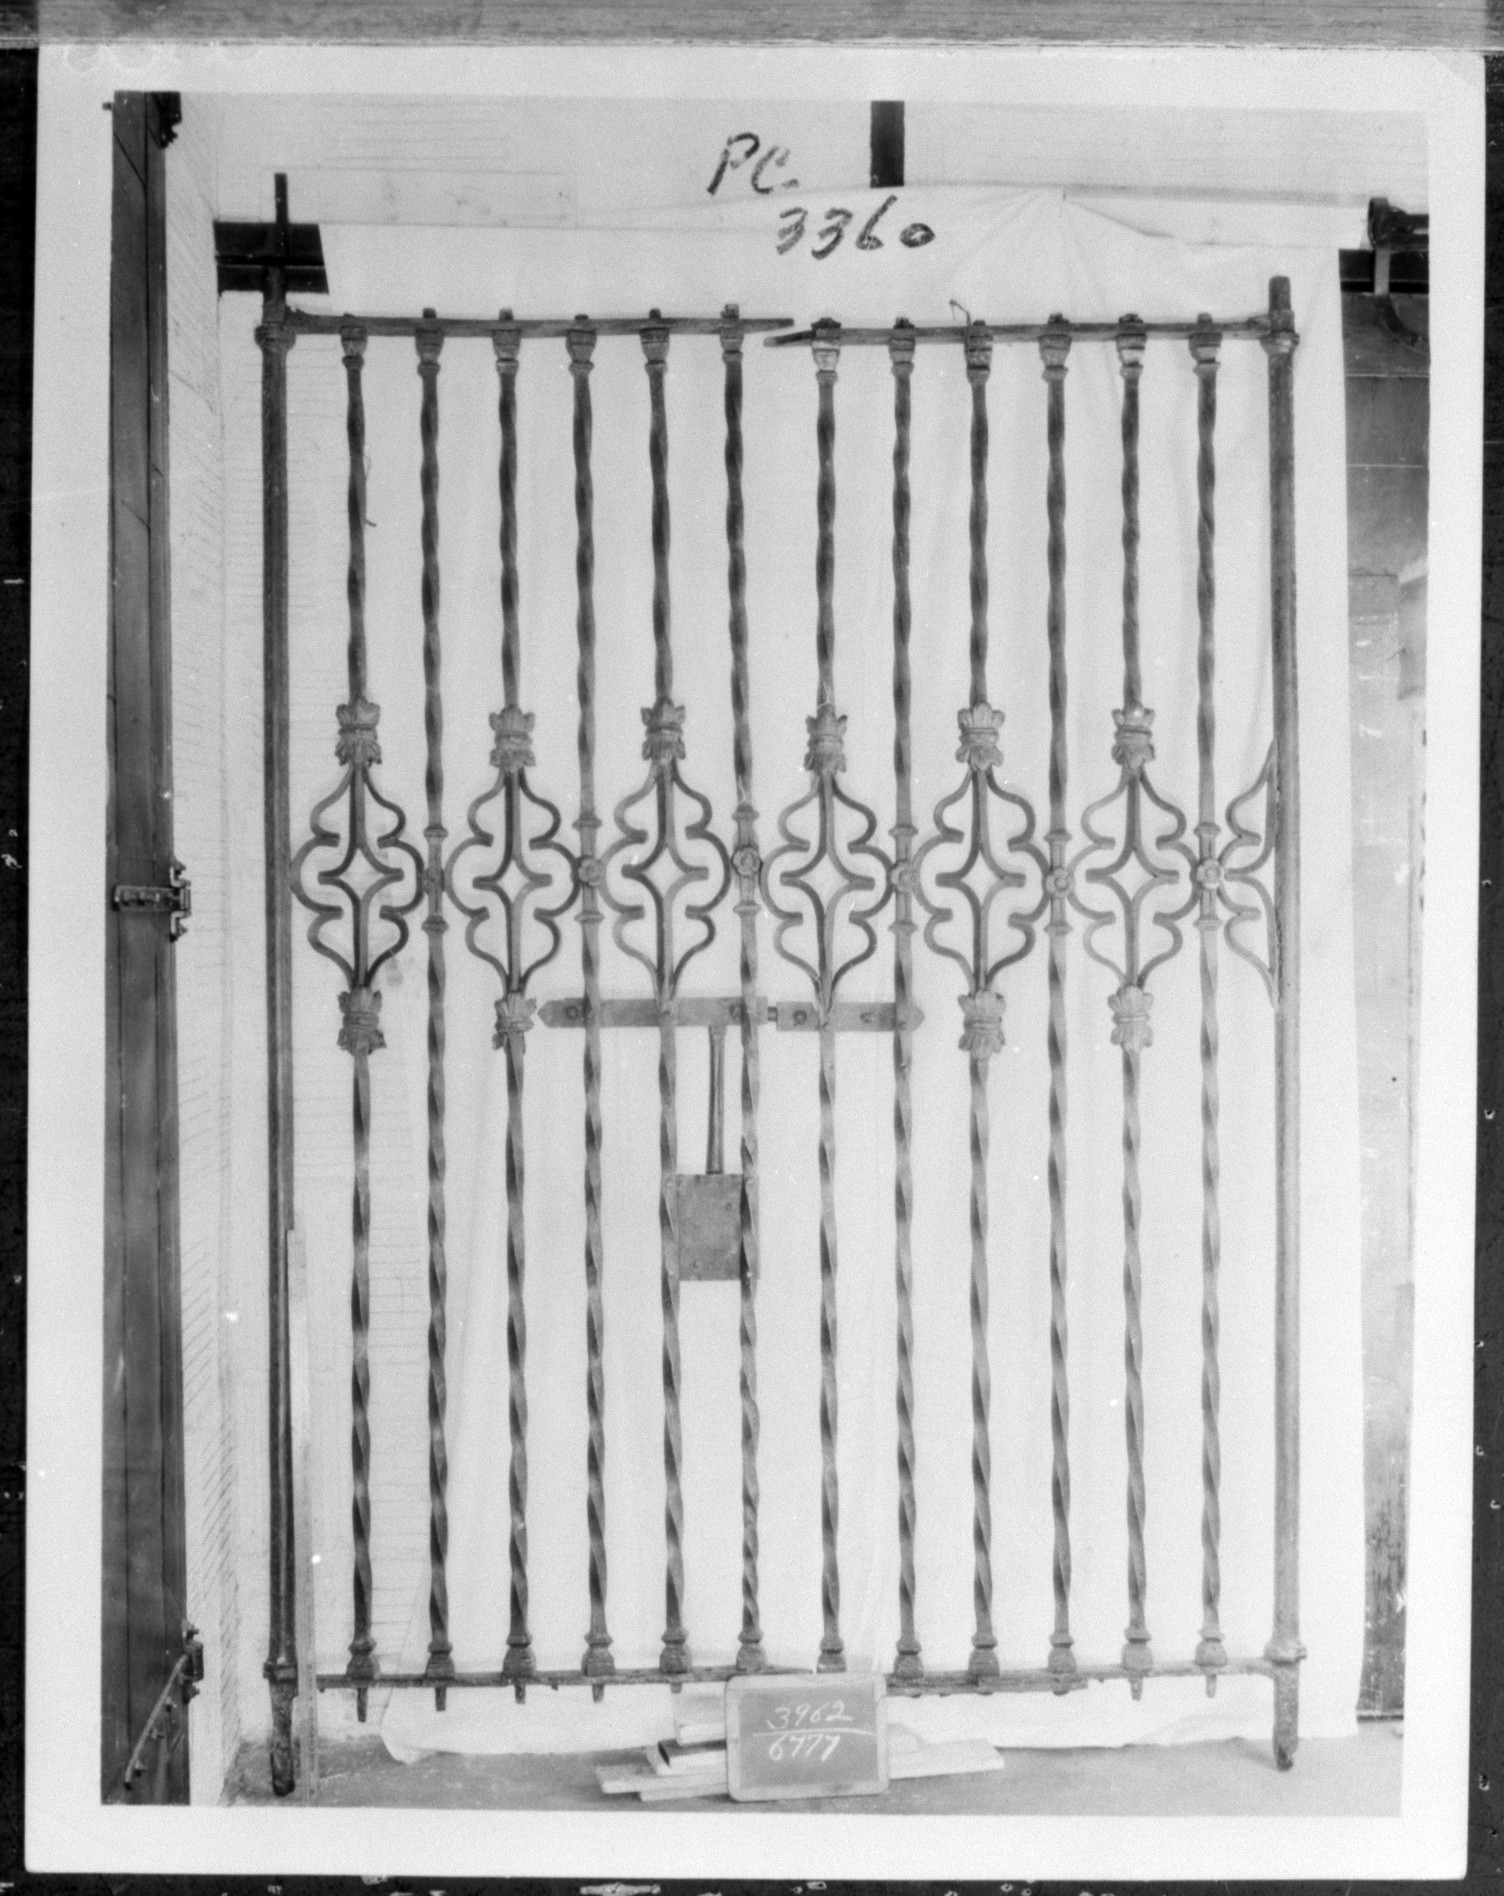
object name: gate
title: Gate (Reja)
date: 1510-1530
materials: iron